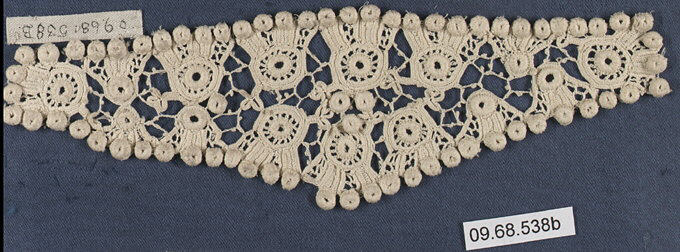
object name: cuff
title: Pair of cuffs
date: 1801-1900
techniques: crochet